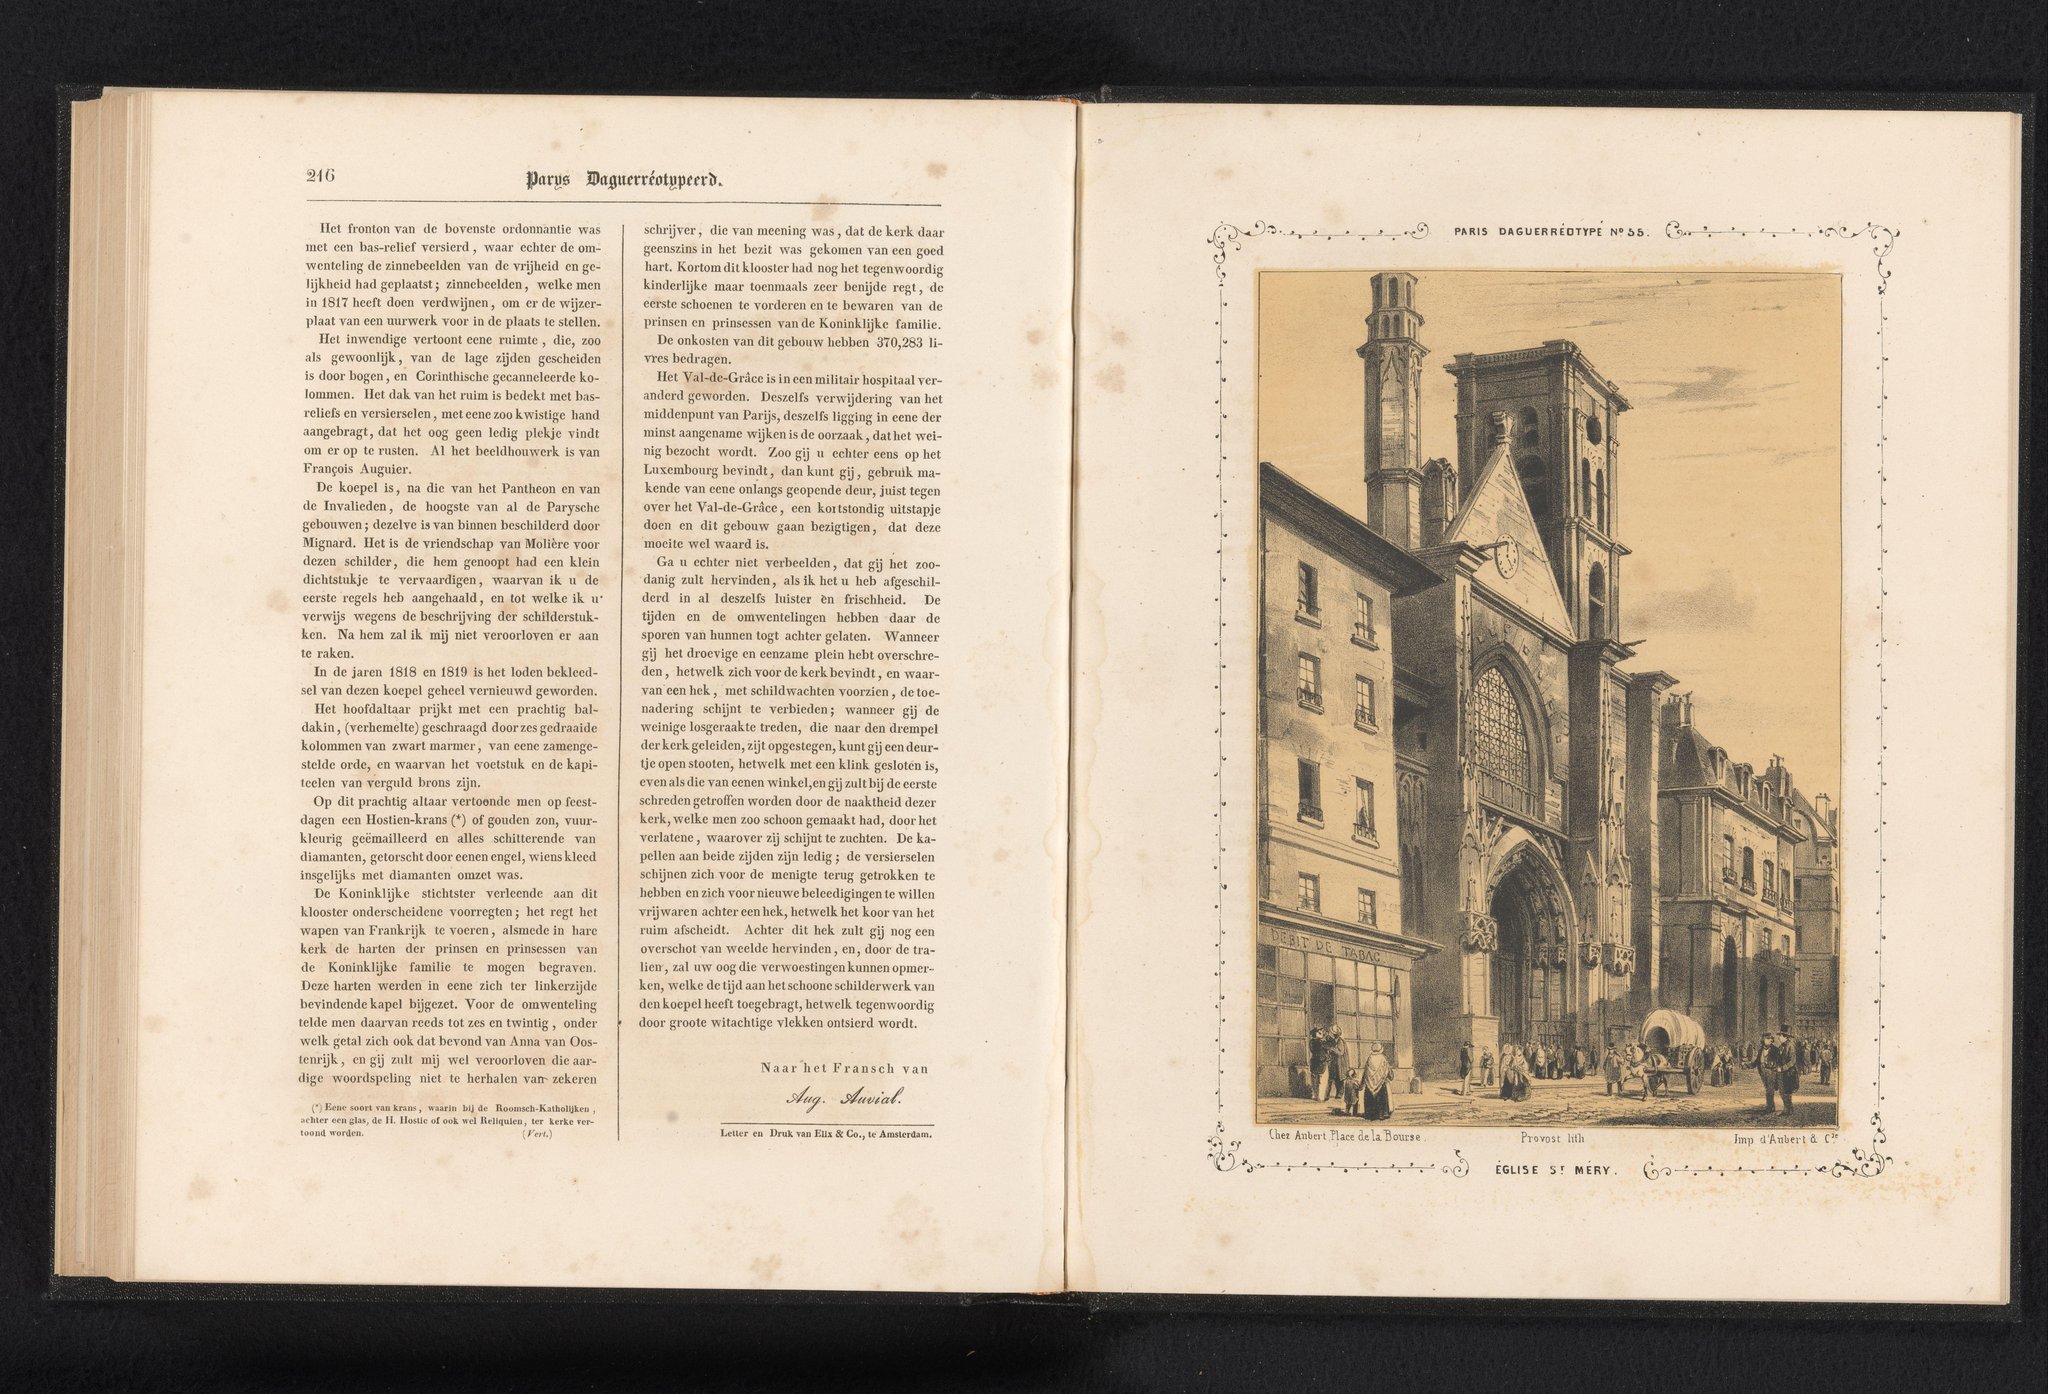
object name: page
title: Église St. Méry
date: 1839-1840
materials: paper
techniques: tone lithography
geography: paris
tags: church (exterior)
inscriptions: inscription: ‘PARIS DAGUERRÉOTYPÉ No. 55.’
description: Prent op tweehonderdnegentiende ongenummerde pagina.